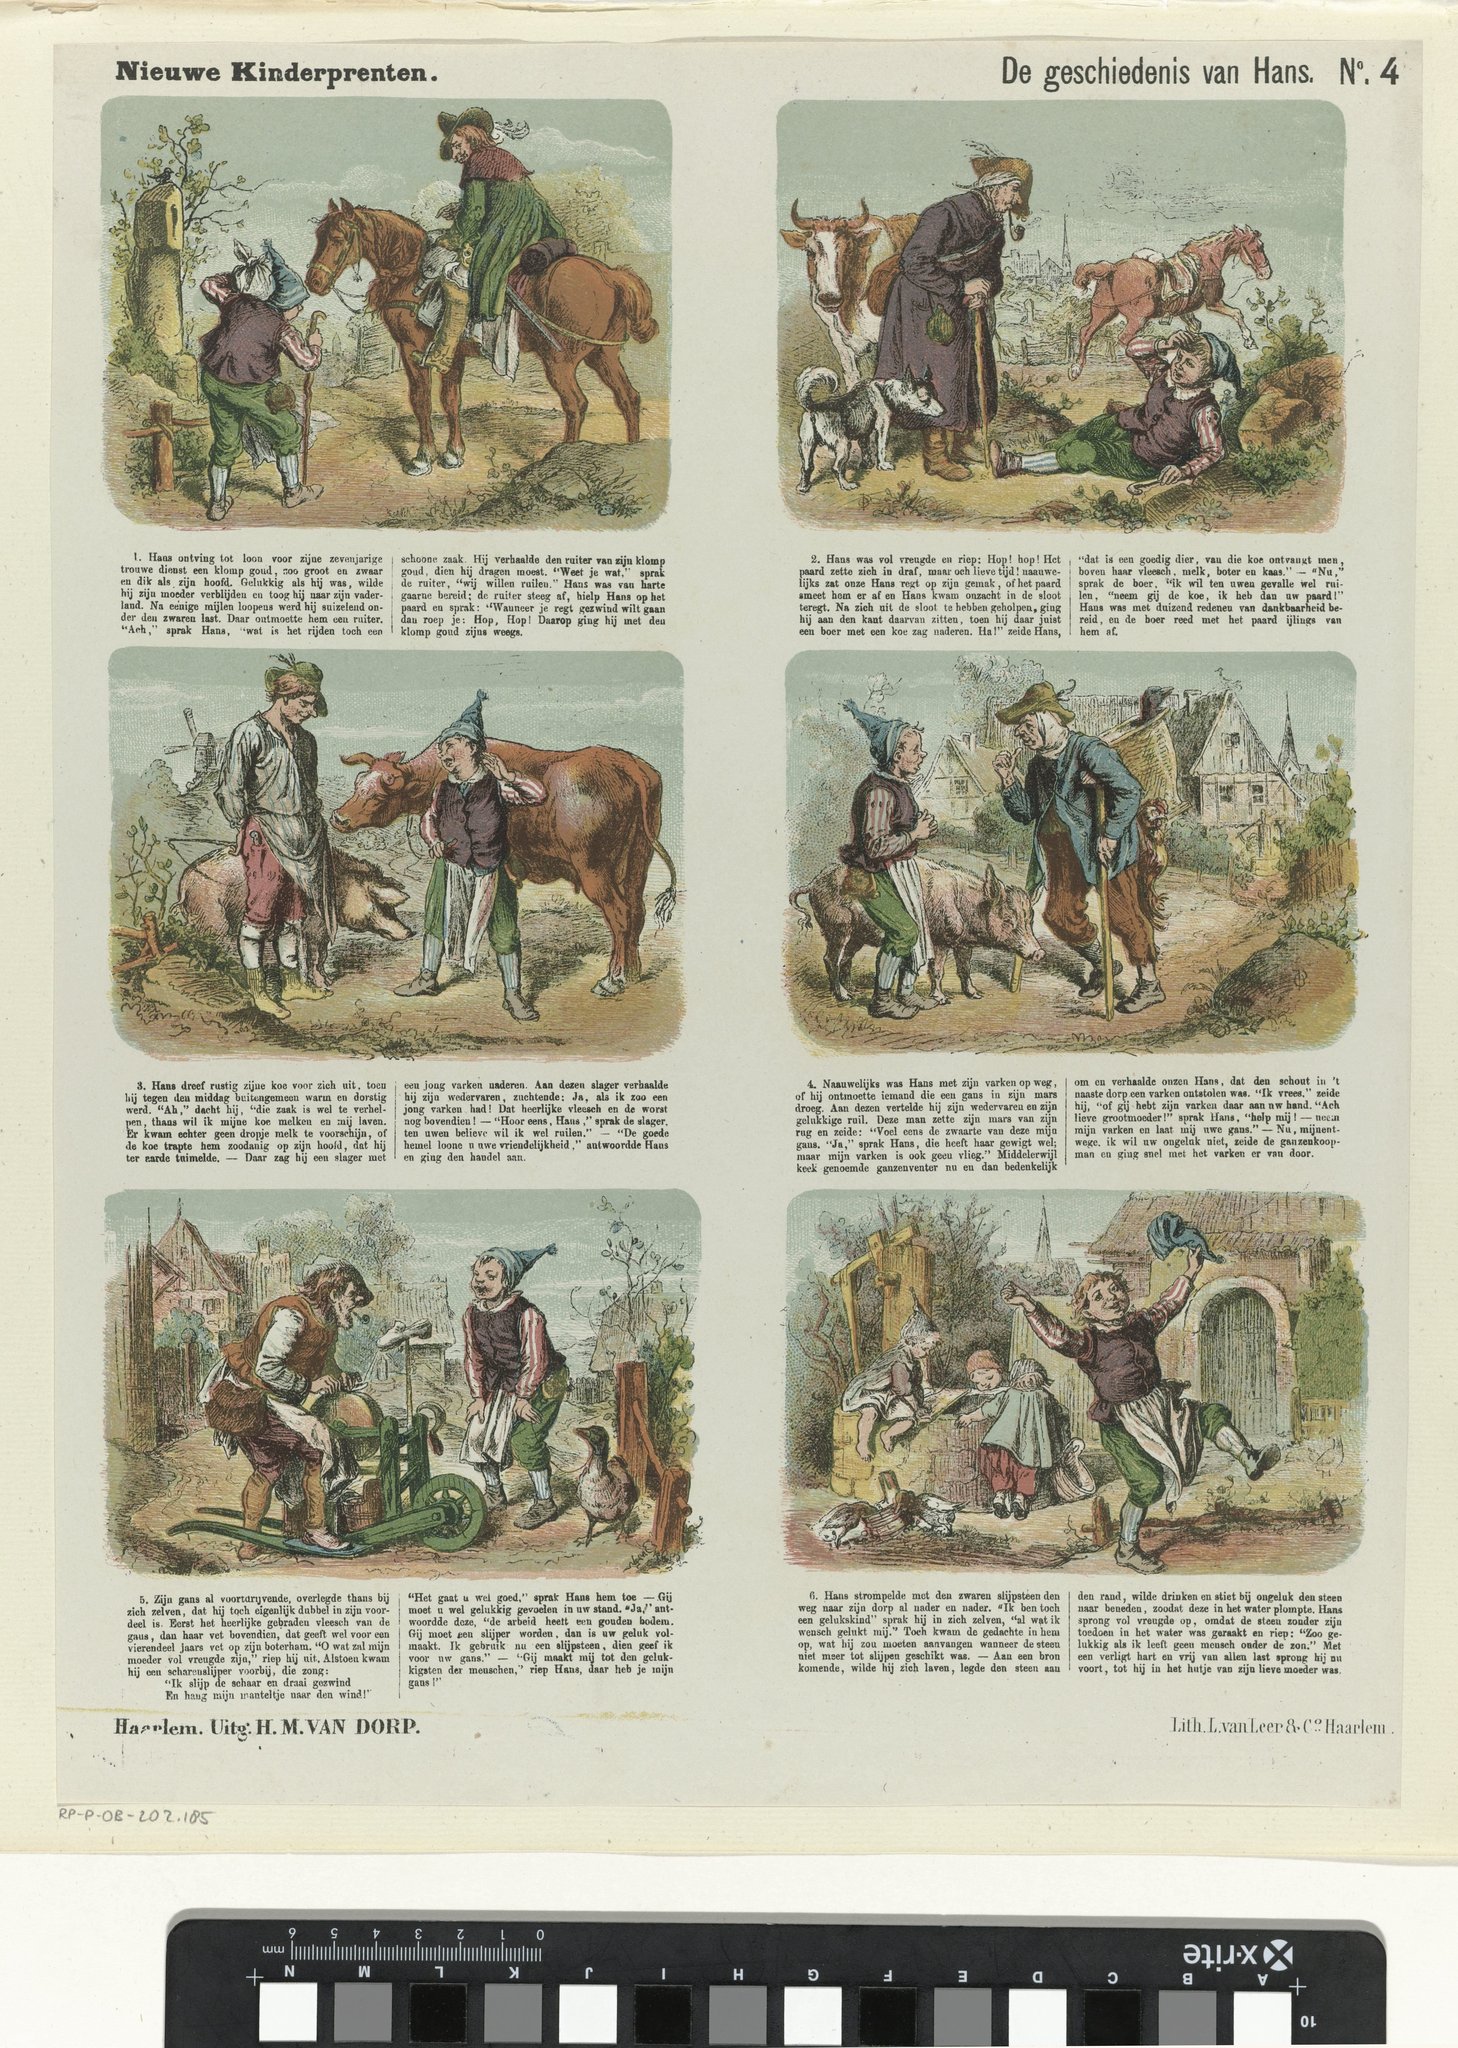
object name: print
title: Nieuwe kinderprenten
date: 1872-1883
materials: paper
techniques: lithograph, letterpress printing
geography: haarlem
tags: animals, parts of machines: mill-stone, tales and fairy tales, horse, trade, commerce and finance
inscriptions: collector's mark: Lugt 2760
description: Blad met 6 voorstellingen over het jongetje Hans dat goud verdiende, dit ruilde voor een paard en zo doorging tot hij eindigde met een molensteen en die in een waterput gooide. Onder elke voorstelling een onderschrift in twee kolommen. Genummerd rechtsboven: No. 4.